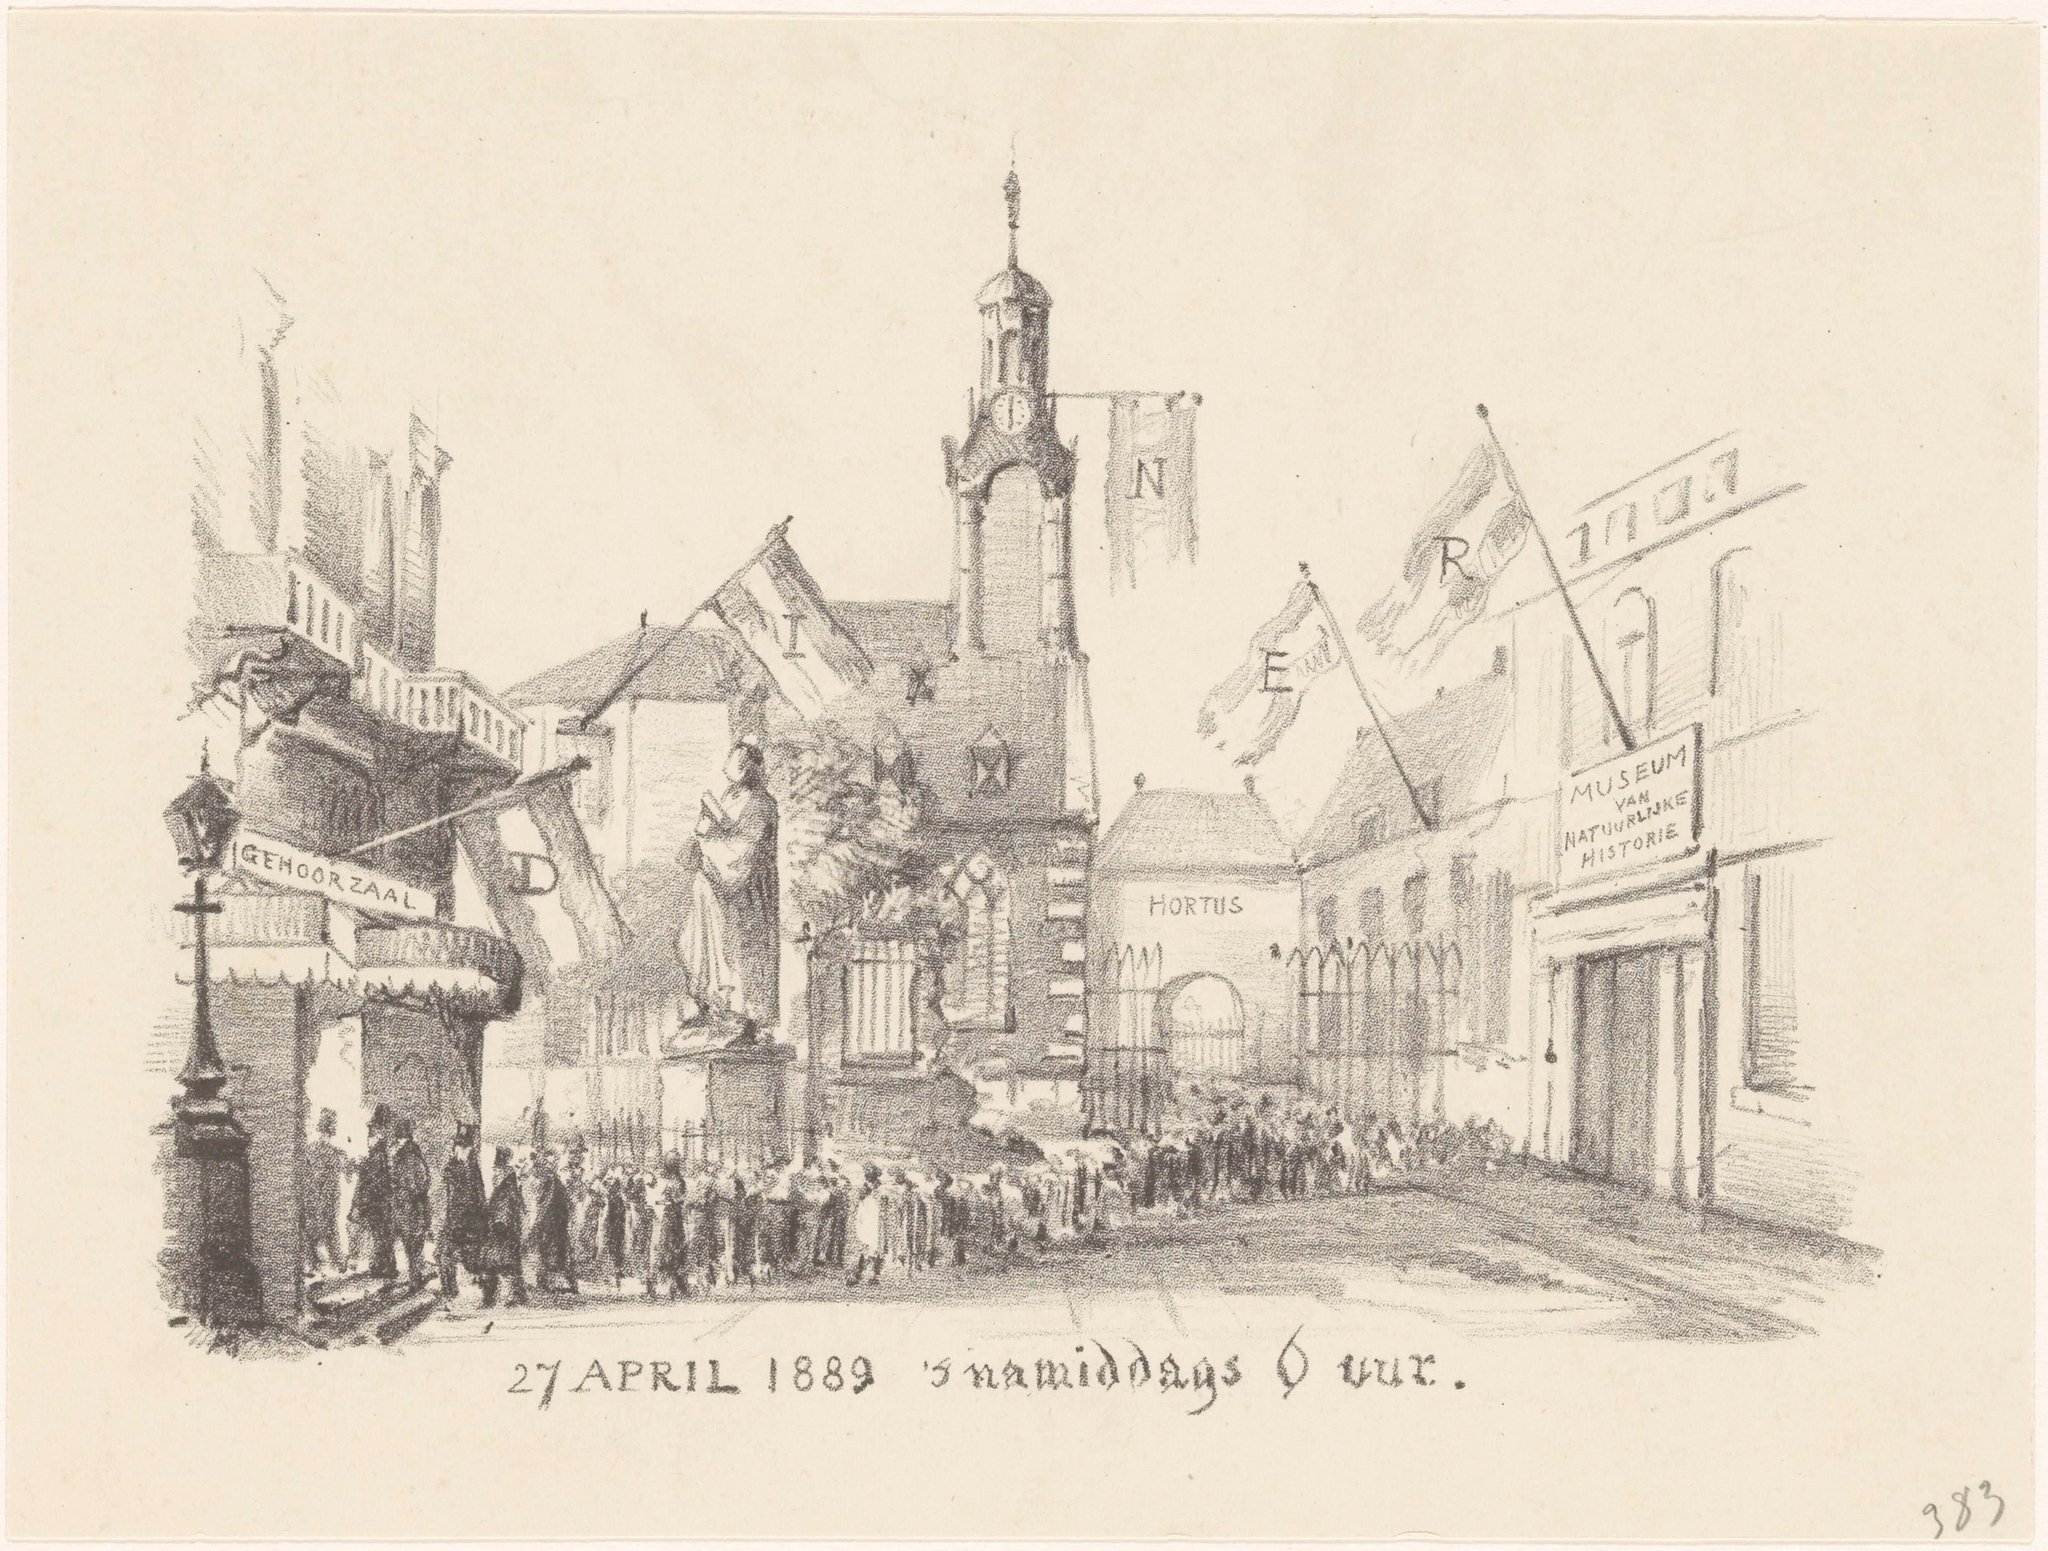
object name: print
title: Dinerkaart met vlaggen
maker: theo van hoytema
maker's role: draughtsman, painter, print maker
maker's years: 1863-1917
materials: paper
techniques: lithograph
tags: flags flown from a mast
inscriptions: collector's mark: Lugt 2228, number: ‘383’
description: Dinerkaart voor 27 april 1889. Vlaggen met de letters DINER uitgestoken bij de gehoorzaal, de hortus en het museum van natuurlijke historie. Er staat een rij mensen bij de ingang van de gehoorzaal.